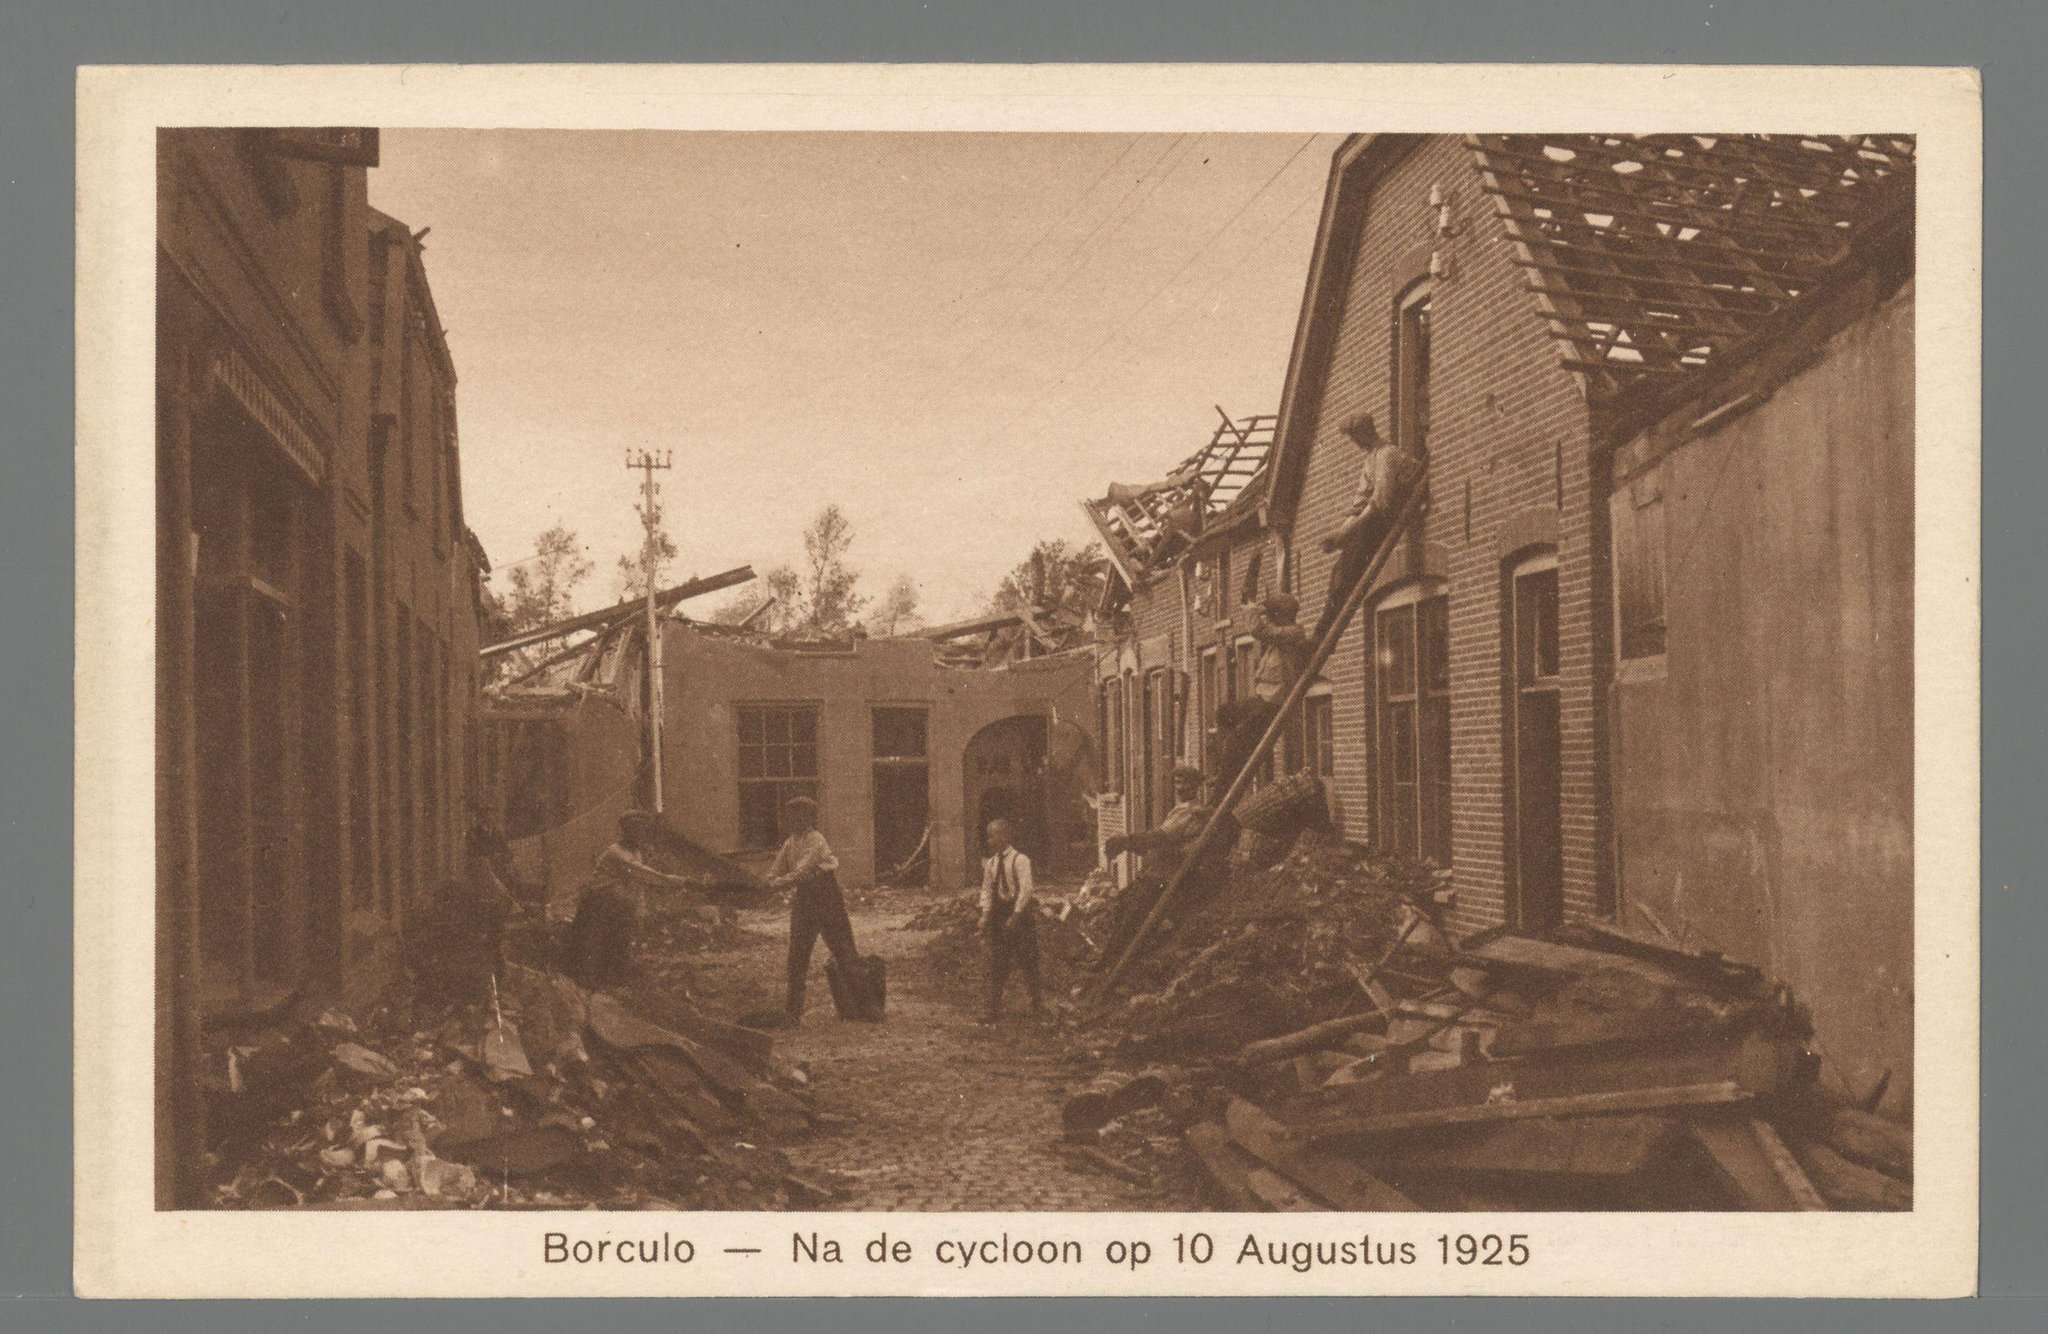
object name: ansichtkaart, prentbriefkaart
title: Borculo - na de cycloon op 10 augustus 1925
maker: Anonymous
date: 1925-1927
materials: cardboard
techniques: rotogravure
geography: borculo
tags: consequences of weather, e.g. after the drought, before the storm, after the cyclone, whirlwind, cyclone, hurricane, typhoon, tornado on land